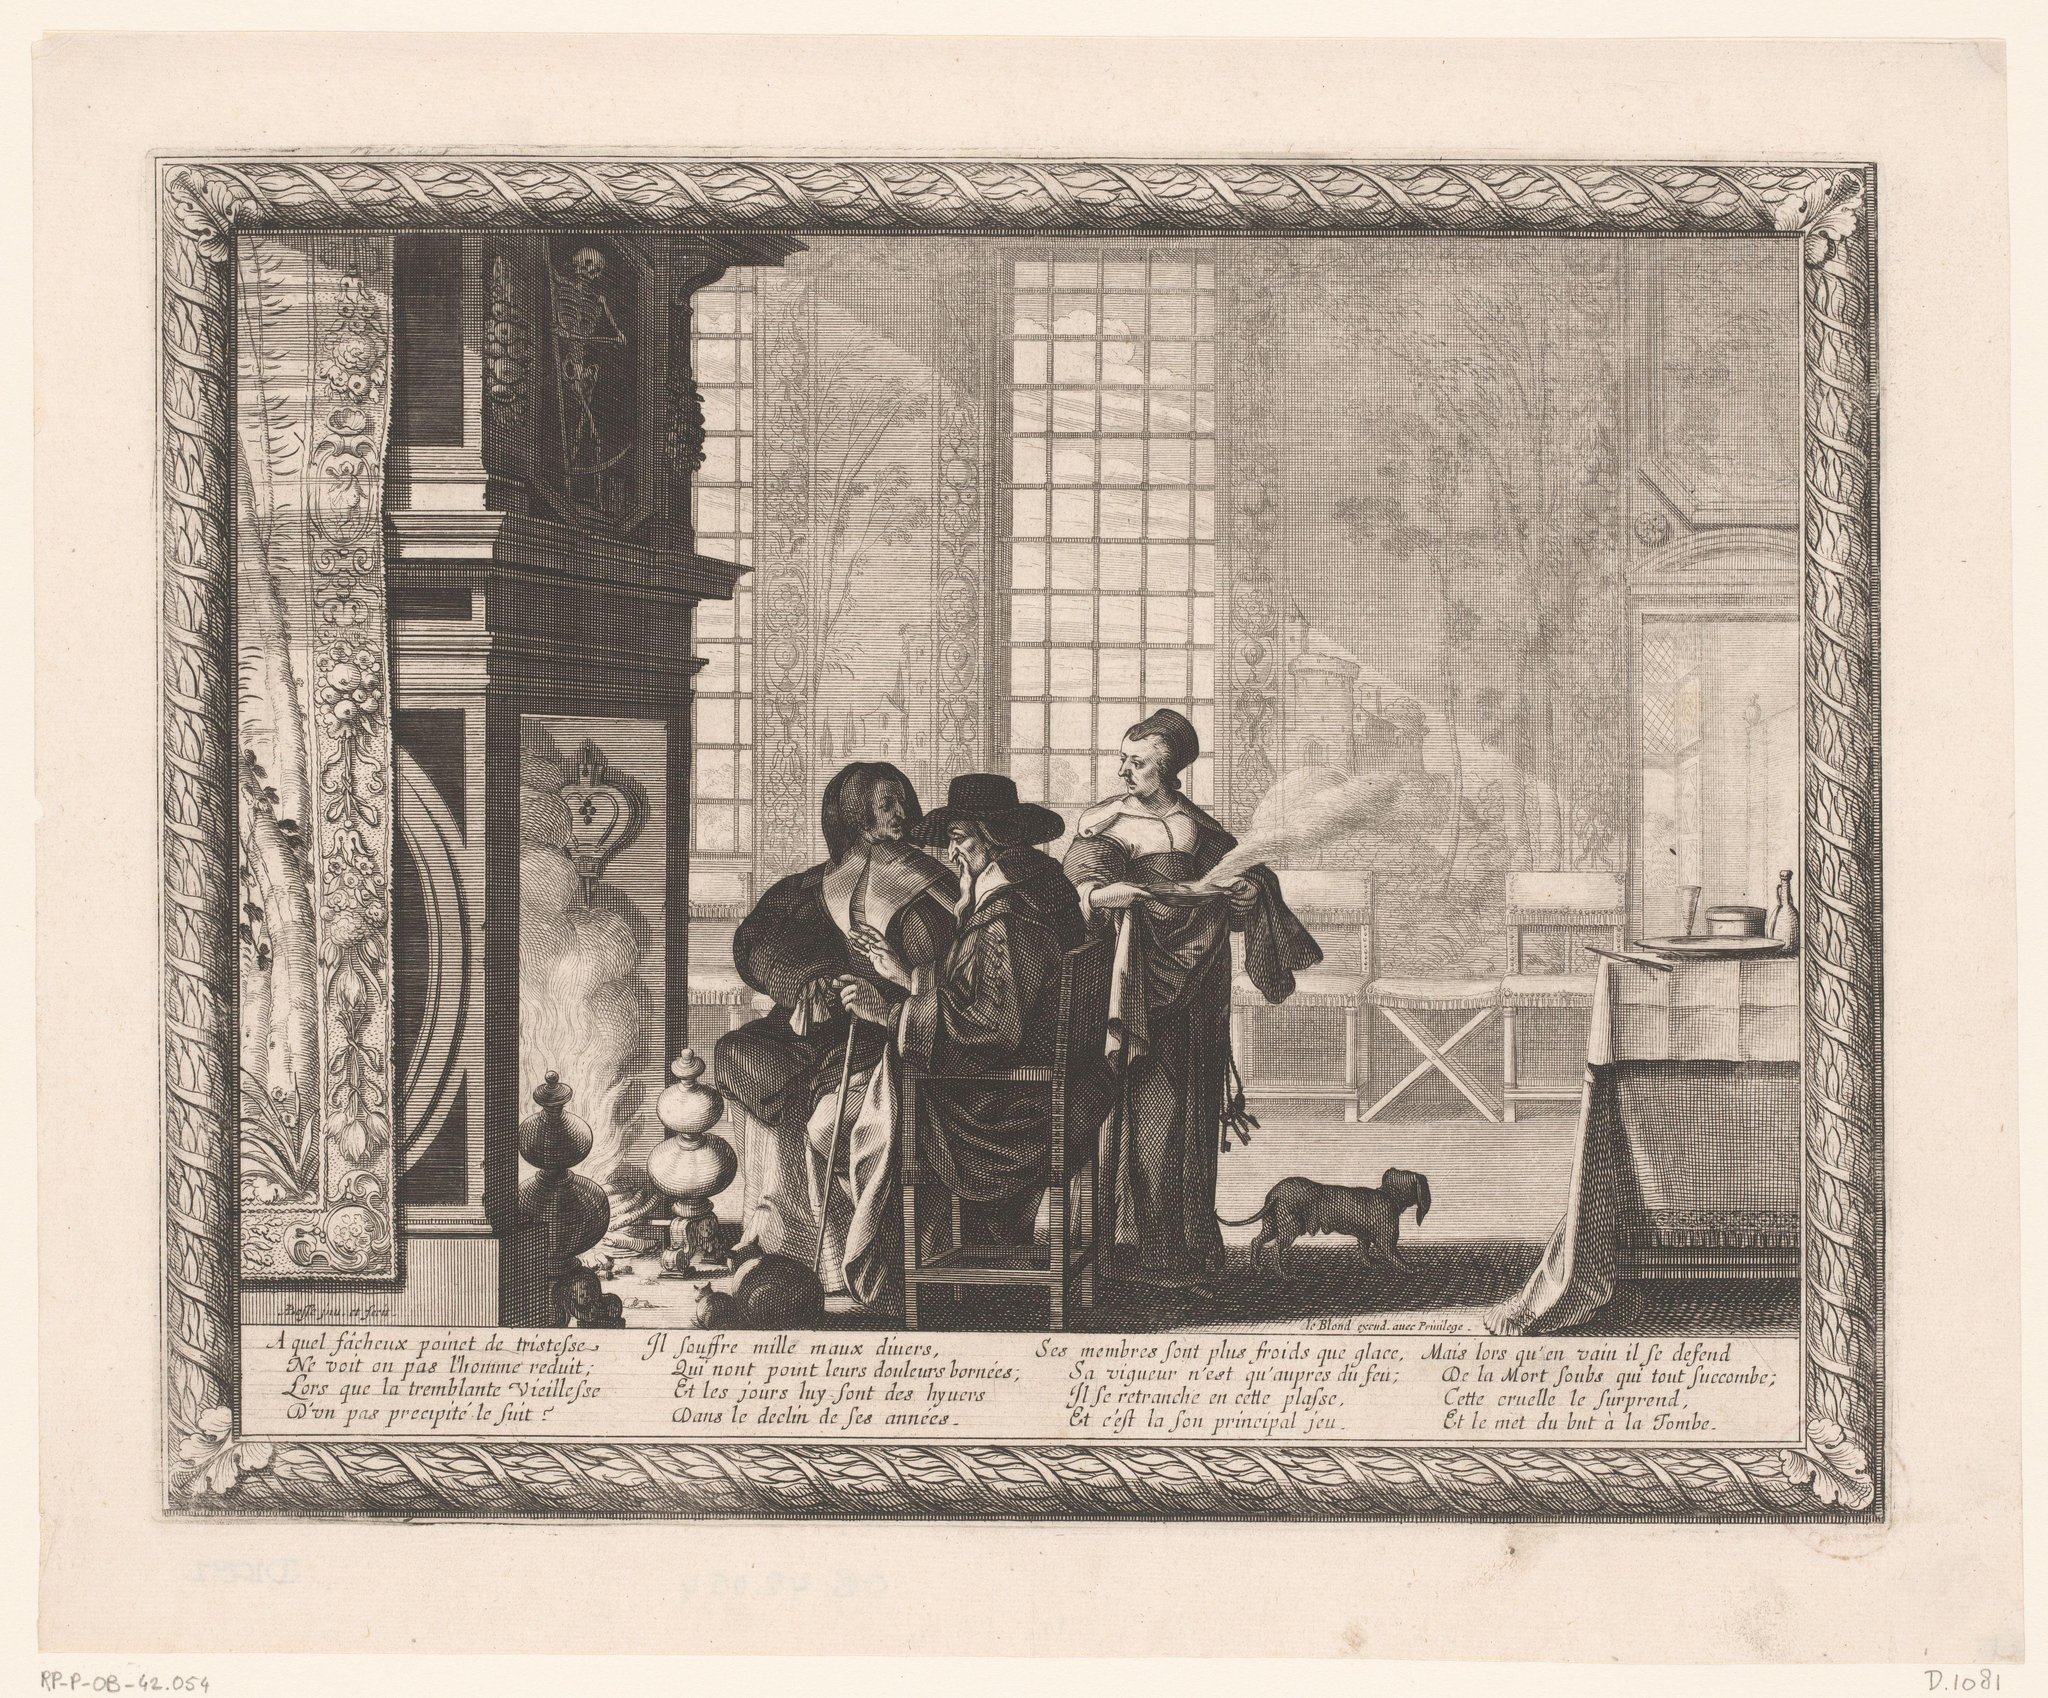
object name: print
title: Vier leeftijden van de mens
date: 1636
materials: paper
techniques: engraving, etching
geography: paris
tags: human life divided into stages, e.g. three, four, seven, twelve stages (with number), old age, 'senectus'; 'vecchiezza' (ripa), the ages of man, open hearth, fire-place, old man, old woman, tapestry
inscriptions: collector's mark: Lugt 240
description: Maakt deel uit van een serie van vier platen met als onderwerp de vier leeftijden van de mens.